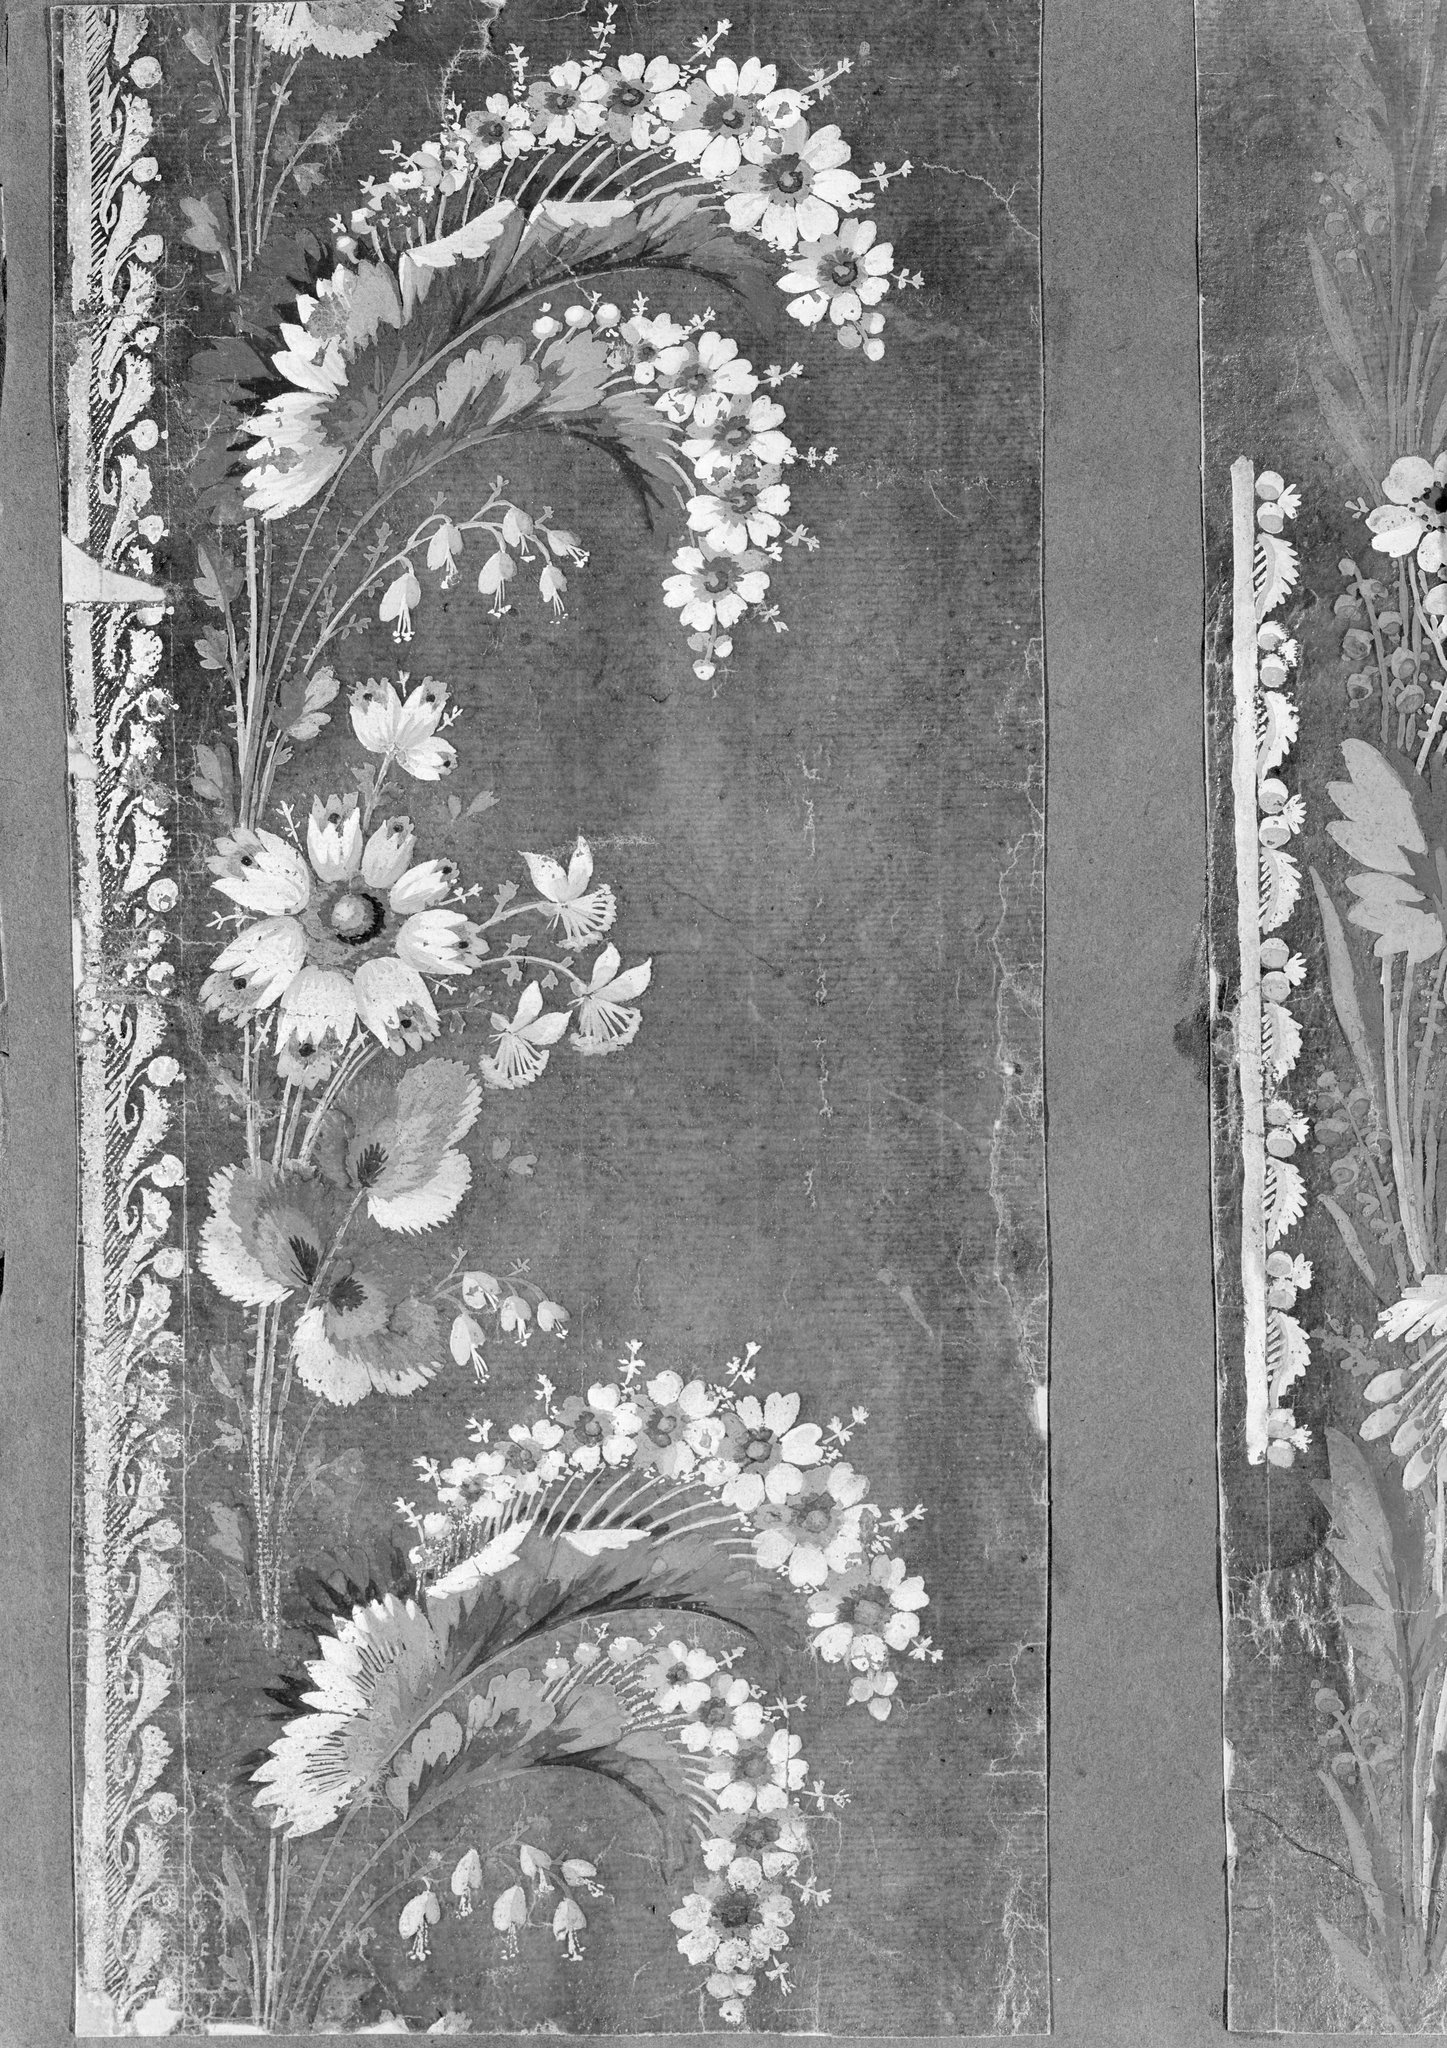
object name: drawing ornament architecture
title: Album of Drawings in Color for Waistcoats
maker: jean françois bony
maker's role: designer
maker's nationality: french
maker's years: 1760-1825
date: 1780-1825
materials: gouache, graphite, ink, watercolor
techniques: pen